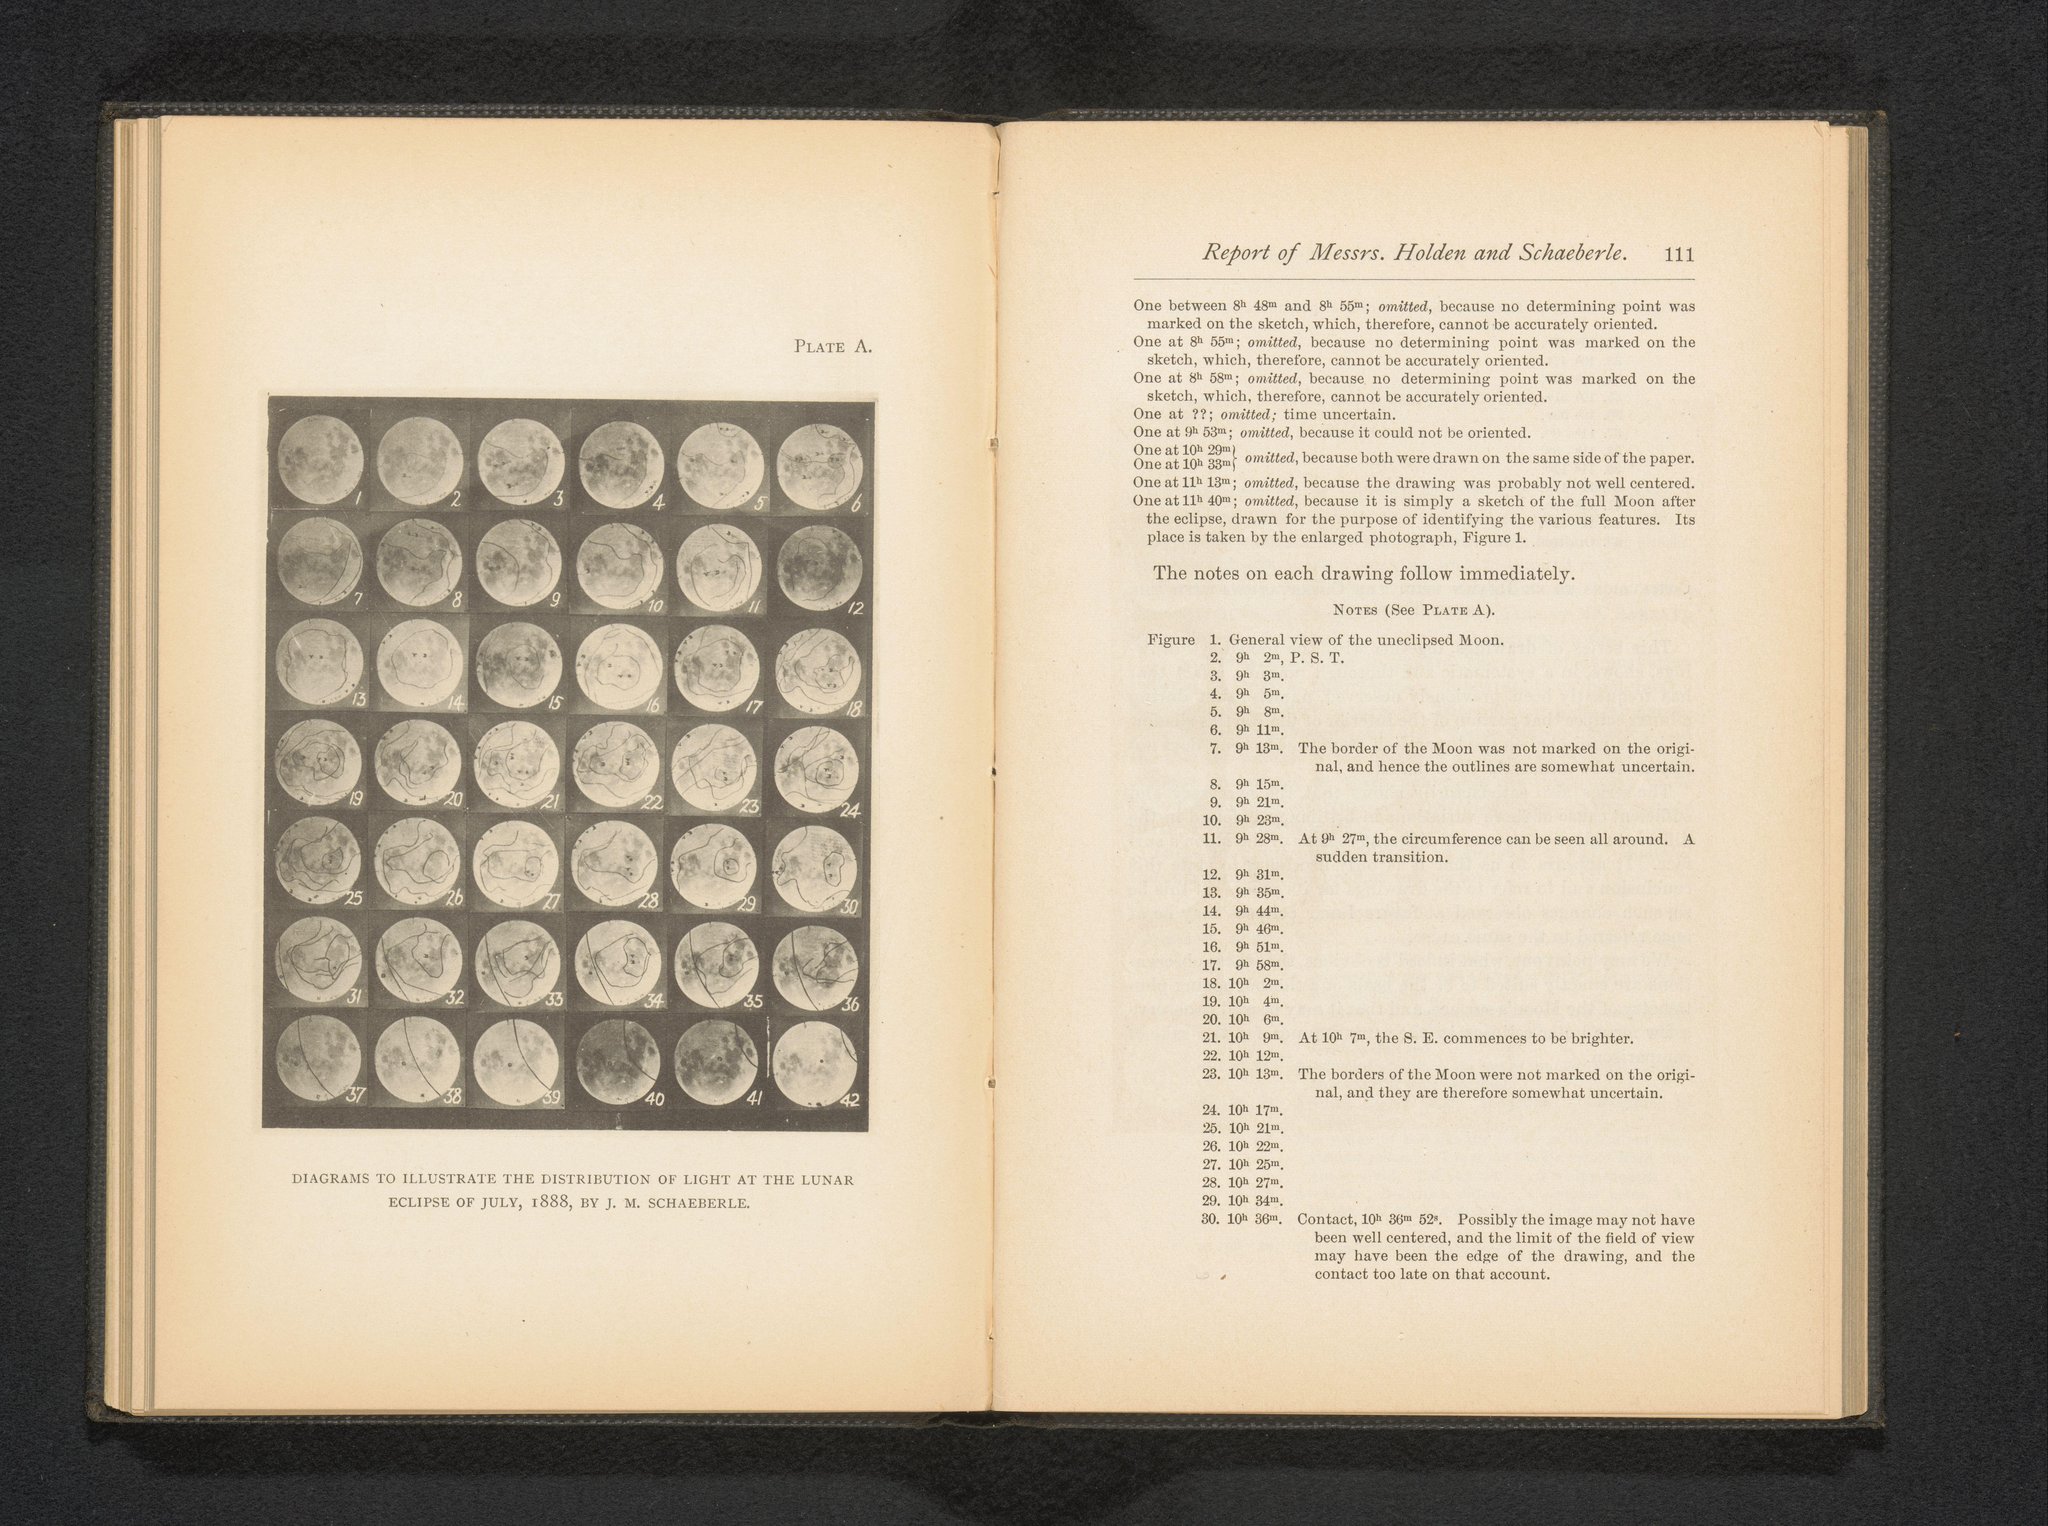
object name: photomechanical print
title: 42 diagrammen die de verspreiding van licht laten zien tijdens de maansverduistering van 22 juli 1888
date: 1888-1891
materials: paper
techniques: photograph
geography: lick observatory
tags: eclipse of the moon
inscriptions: number: ‘Plate A.’, inscription: ‘DIAGRAMS TO ILLUSTRATE THE DISTRIBUTION OF LIGHT AT THE LUNAR/ ECLIPSE OF JULY, 1888, BY J. M. SCHAEBERLE.’